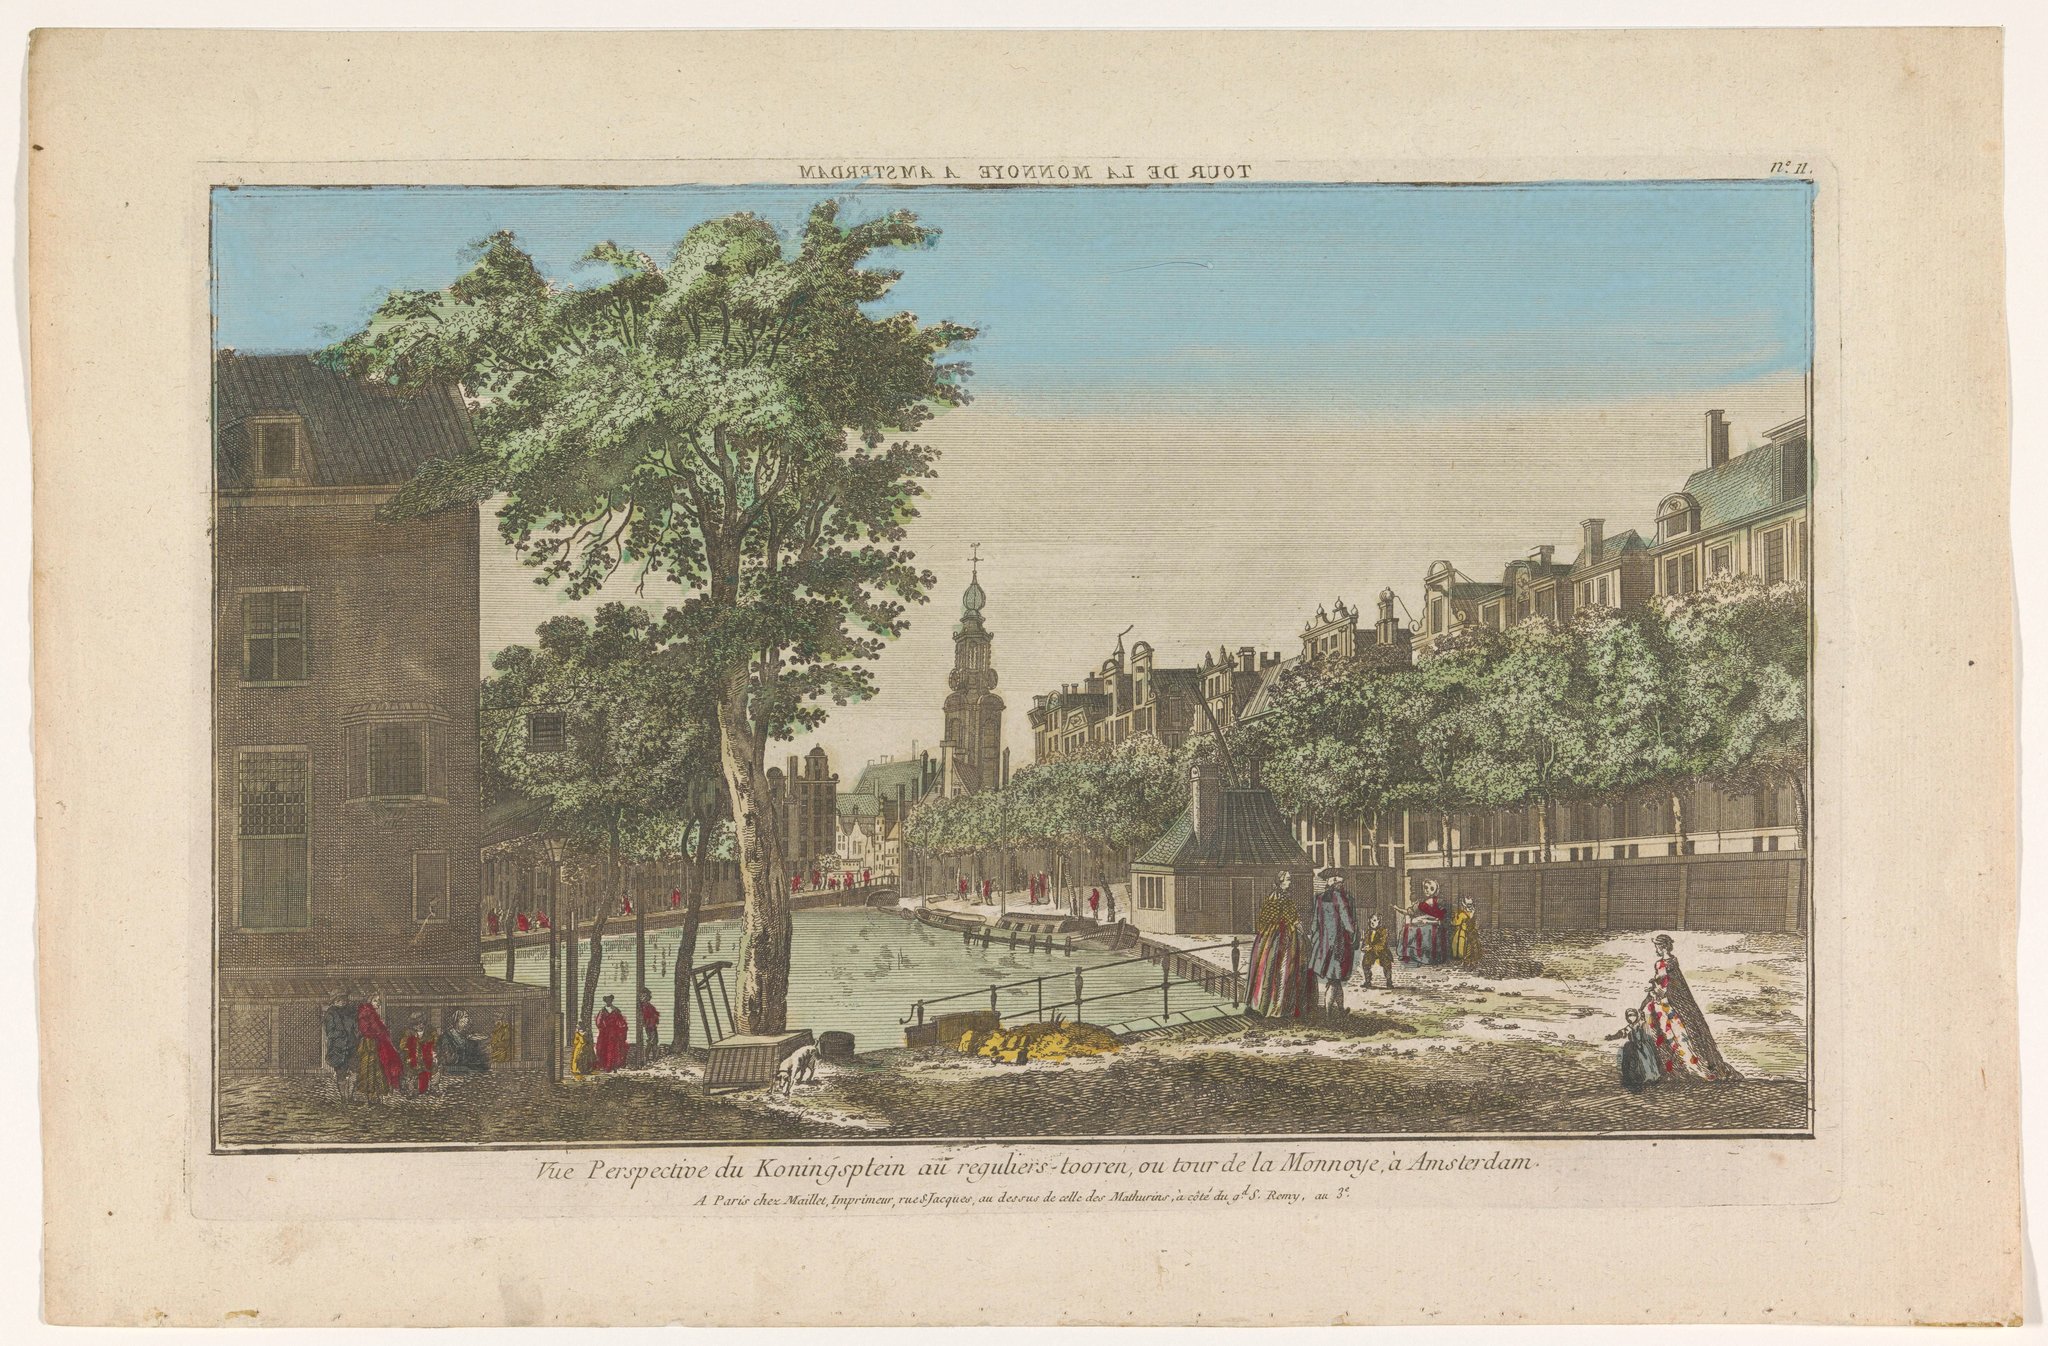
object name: print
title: Gezicht op het Koningsplein en de Munttoren te Amsterdam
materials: paper, watercolor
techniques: brush, etching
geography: paris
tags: tower, clock tower ~ monumental adornment, square, place, circus, etc. (+ city(-scape) with figures, staffage), canals, waters (in city) (+ city(-scape) with figures, staffage)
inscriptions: watermark, collector's mark: Lugt 2166